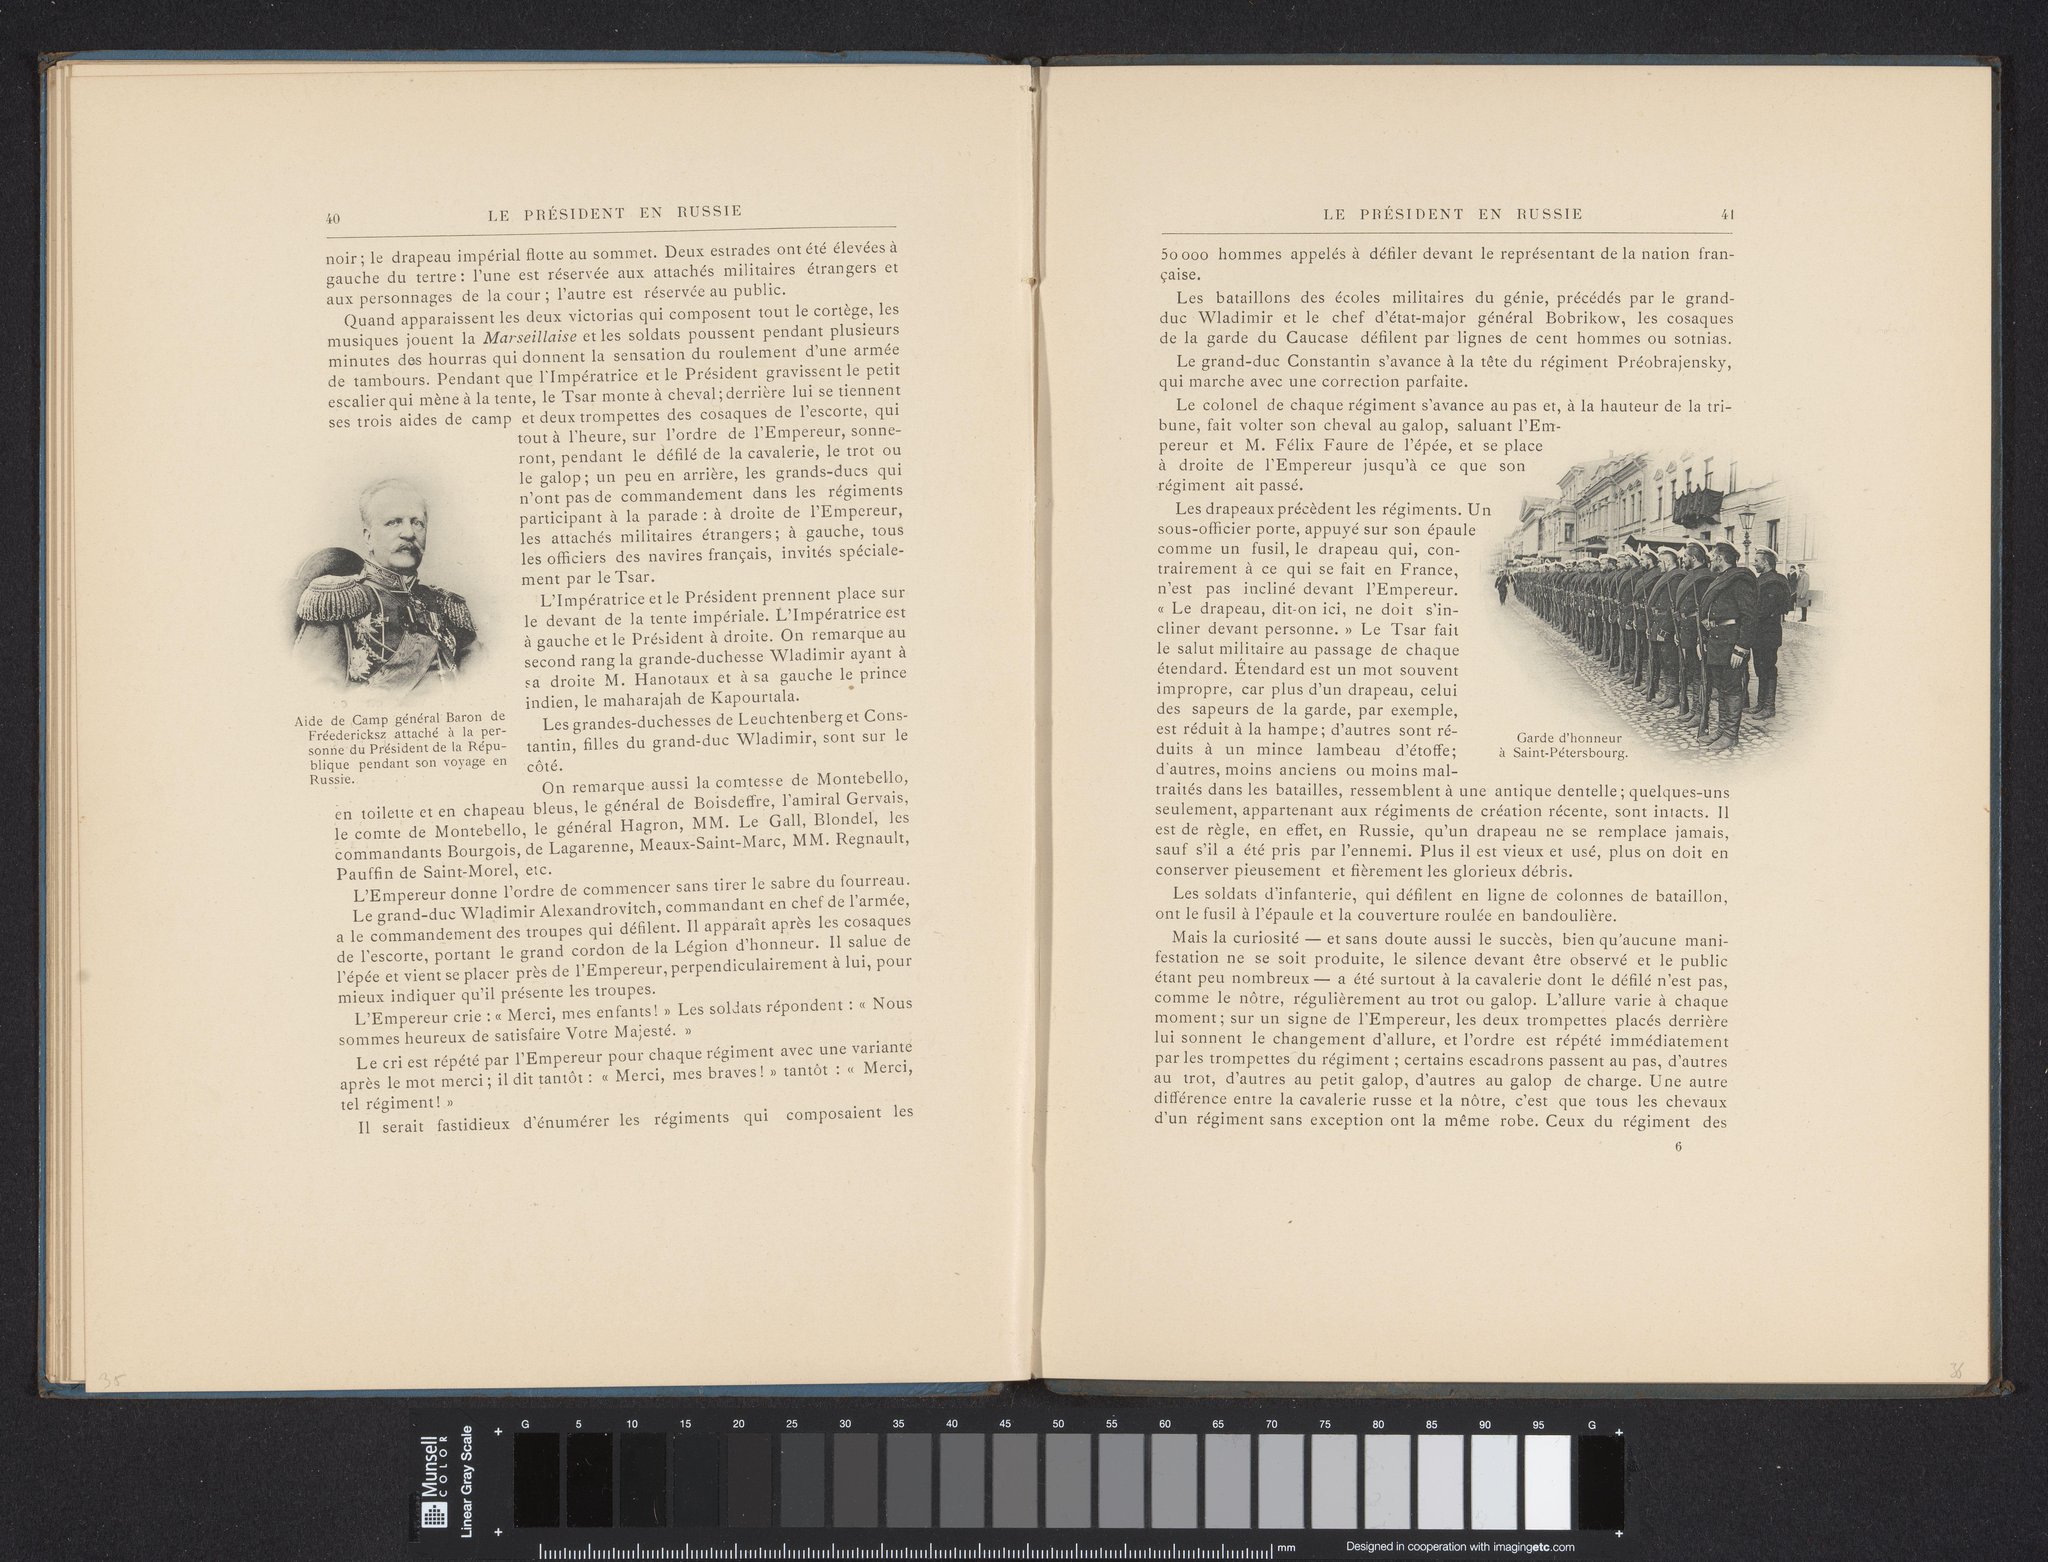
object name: page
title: Portret van baron Adolf Freedericksz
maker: Anonymous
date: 1897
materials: paper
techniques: photograph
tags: historical persons (+ (full) bust portrait)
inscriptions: inscription: ‘Aide du Camp (...) Russie.’